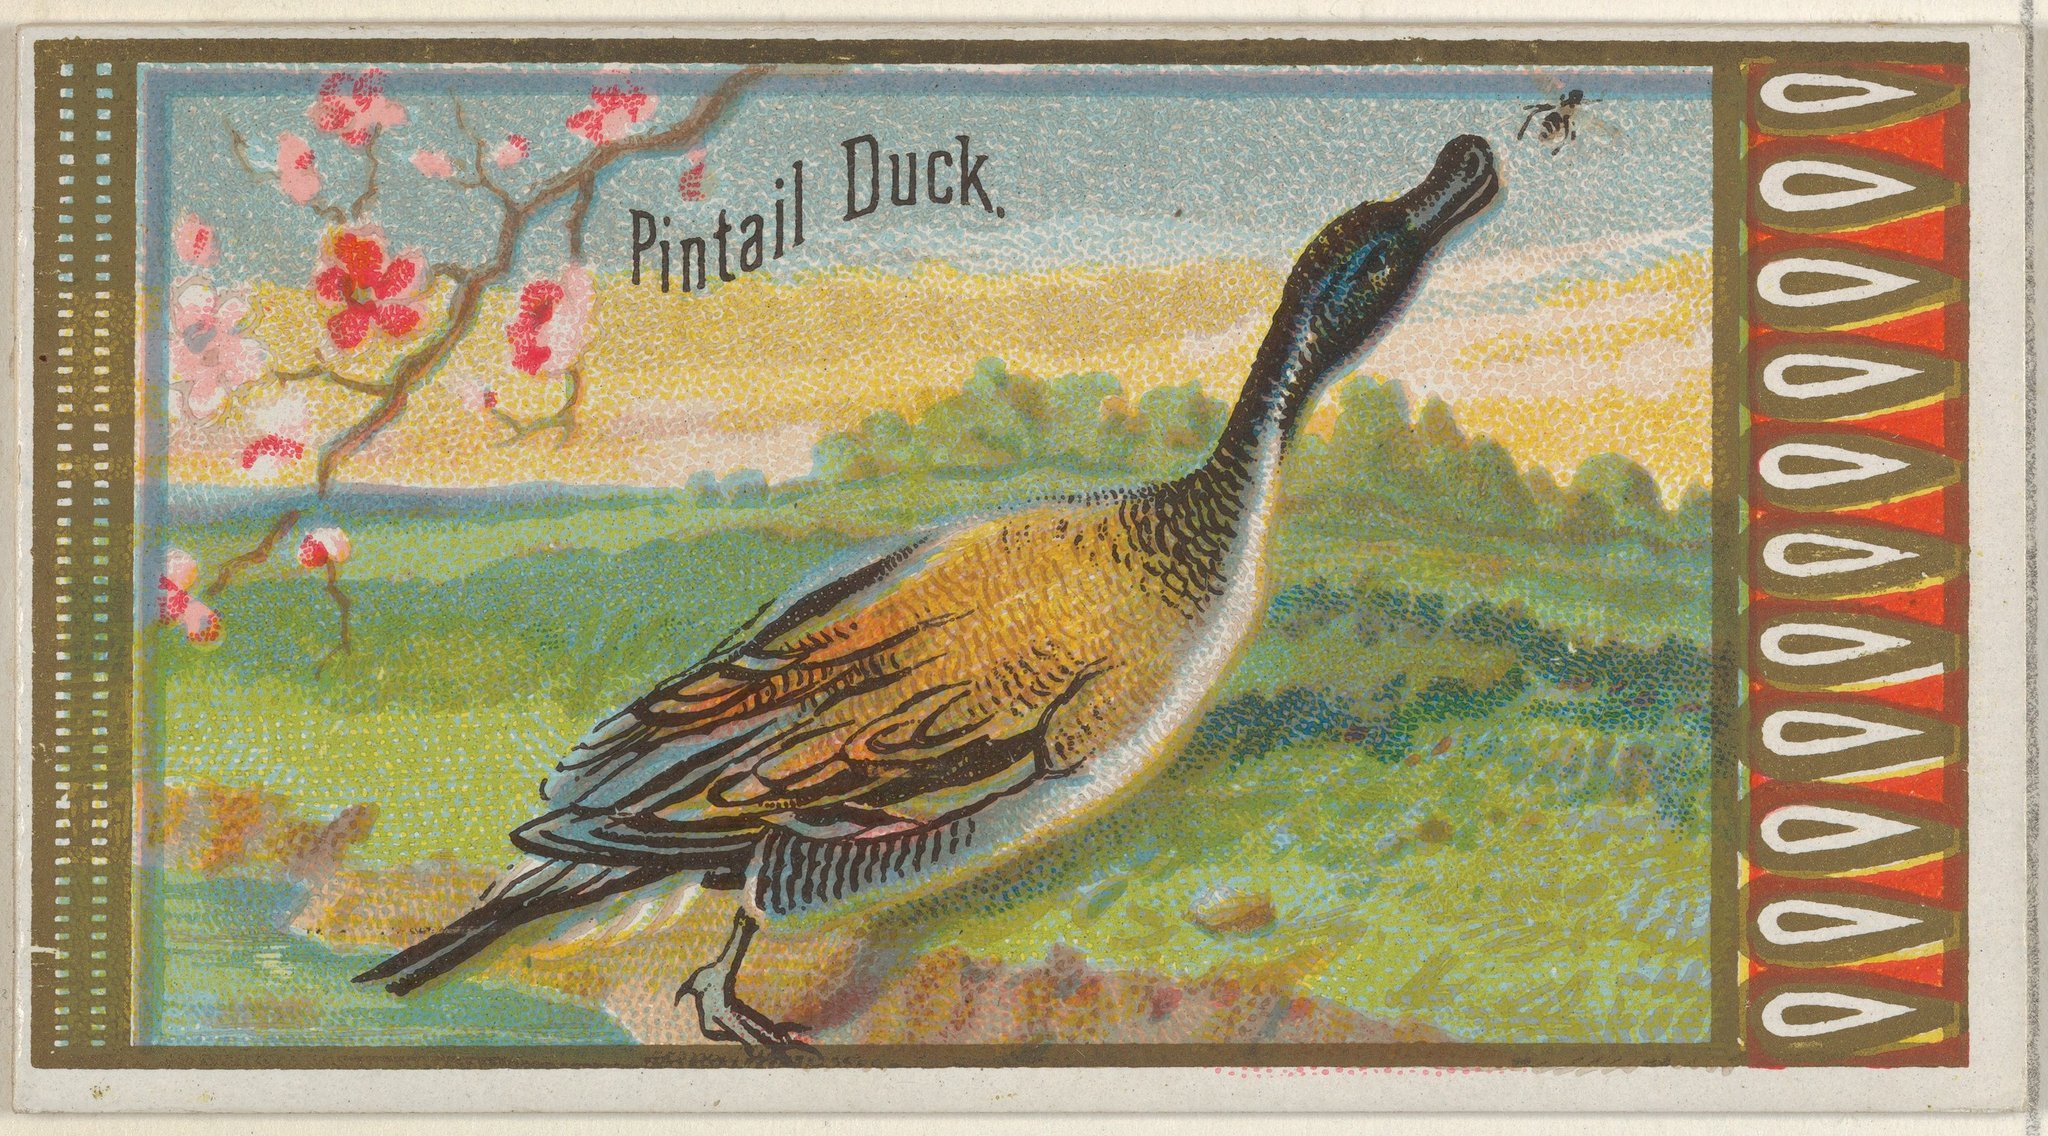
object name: print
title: Pintail Duck, from the Game Birds series (N13) for Allen & Ginter Cigarettes Brands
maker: allen & ginter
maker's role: publisher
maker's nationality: american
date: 1889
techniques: color lithograph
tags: ducks,flowers